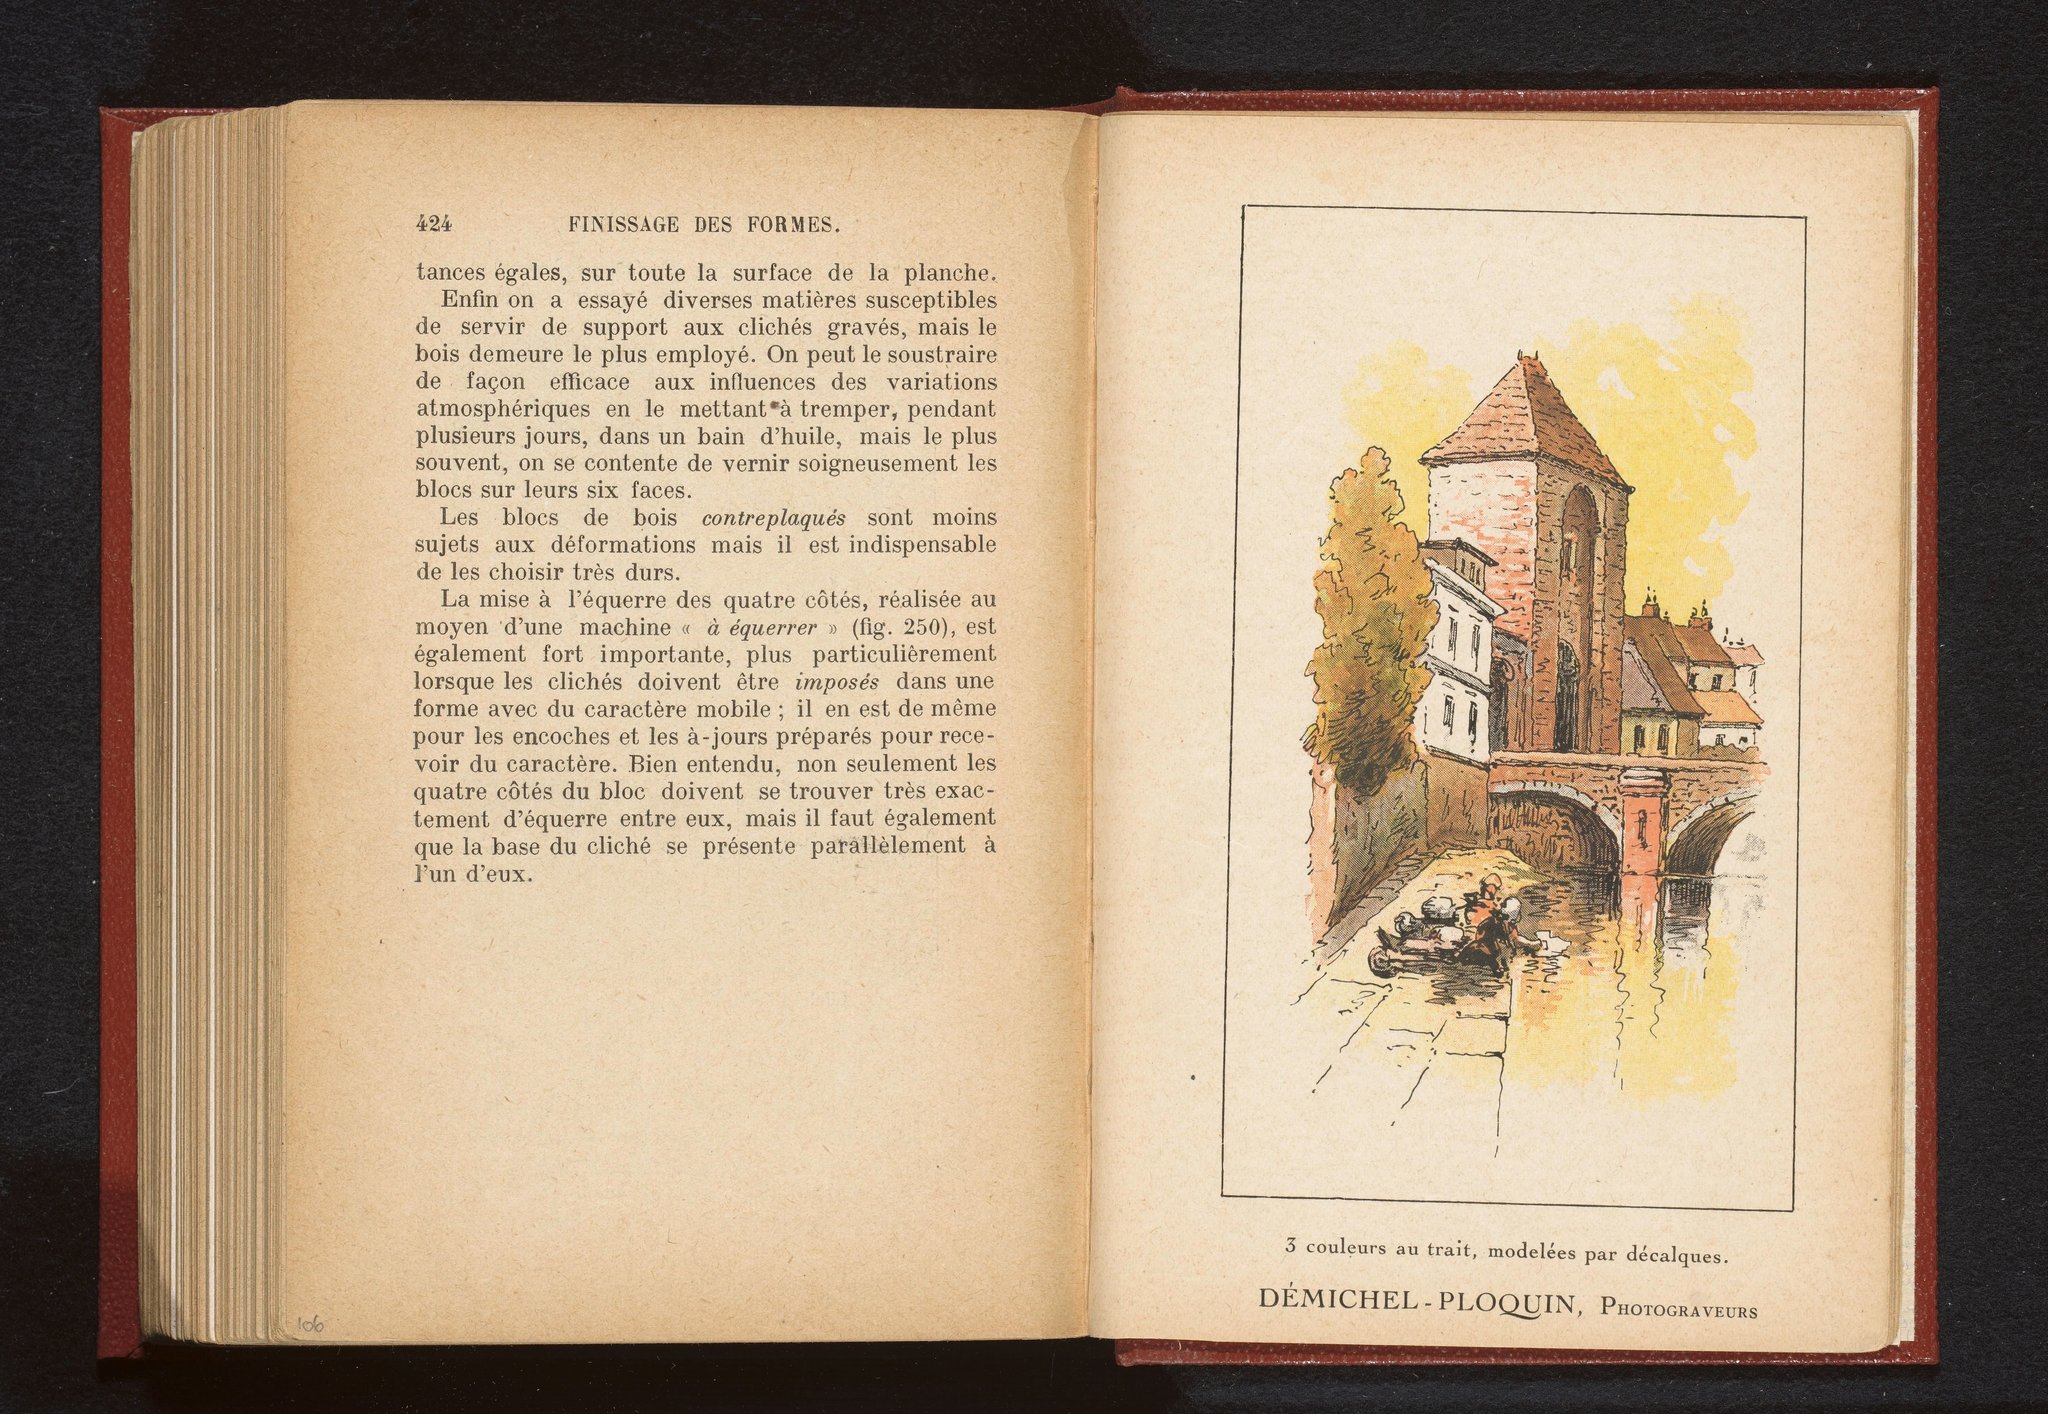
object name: photomechanical print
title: 3 couleurs au trait, modelées par décalques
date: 1922-1932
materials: paper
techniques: line block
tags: drawing, sketch, tower, clock tower ~ monumental adornment, bridge